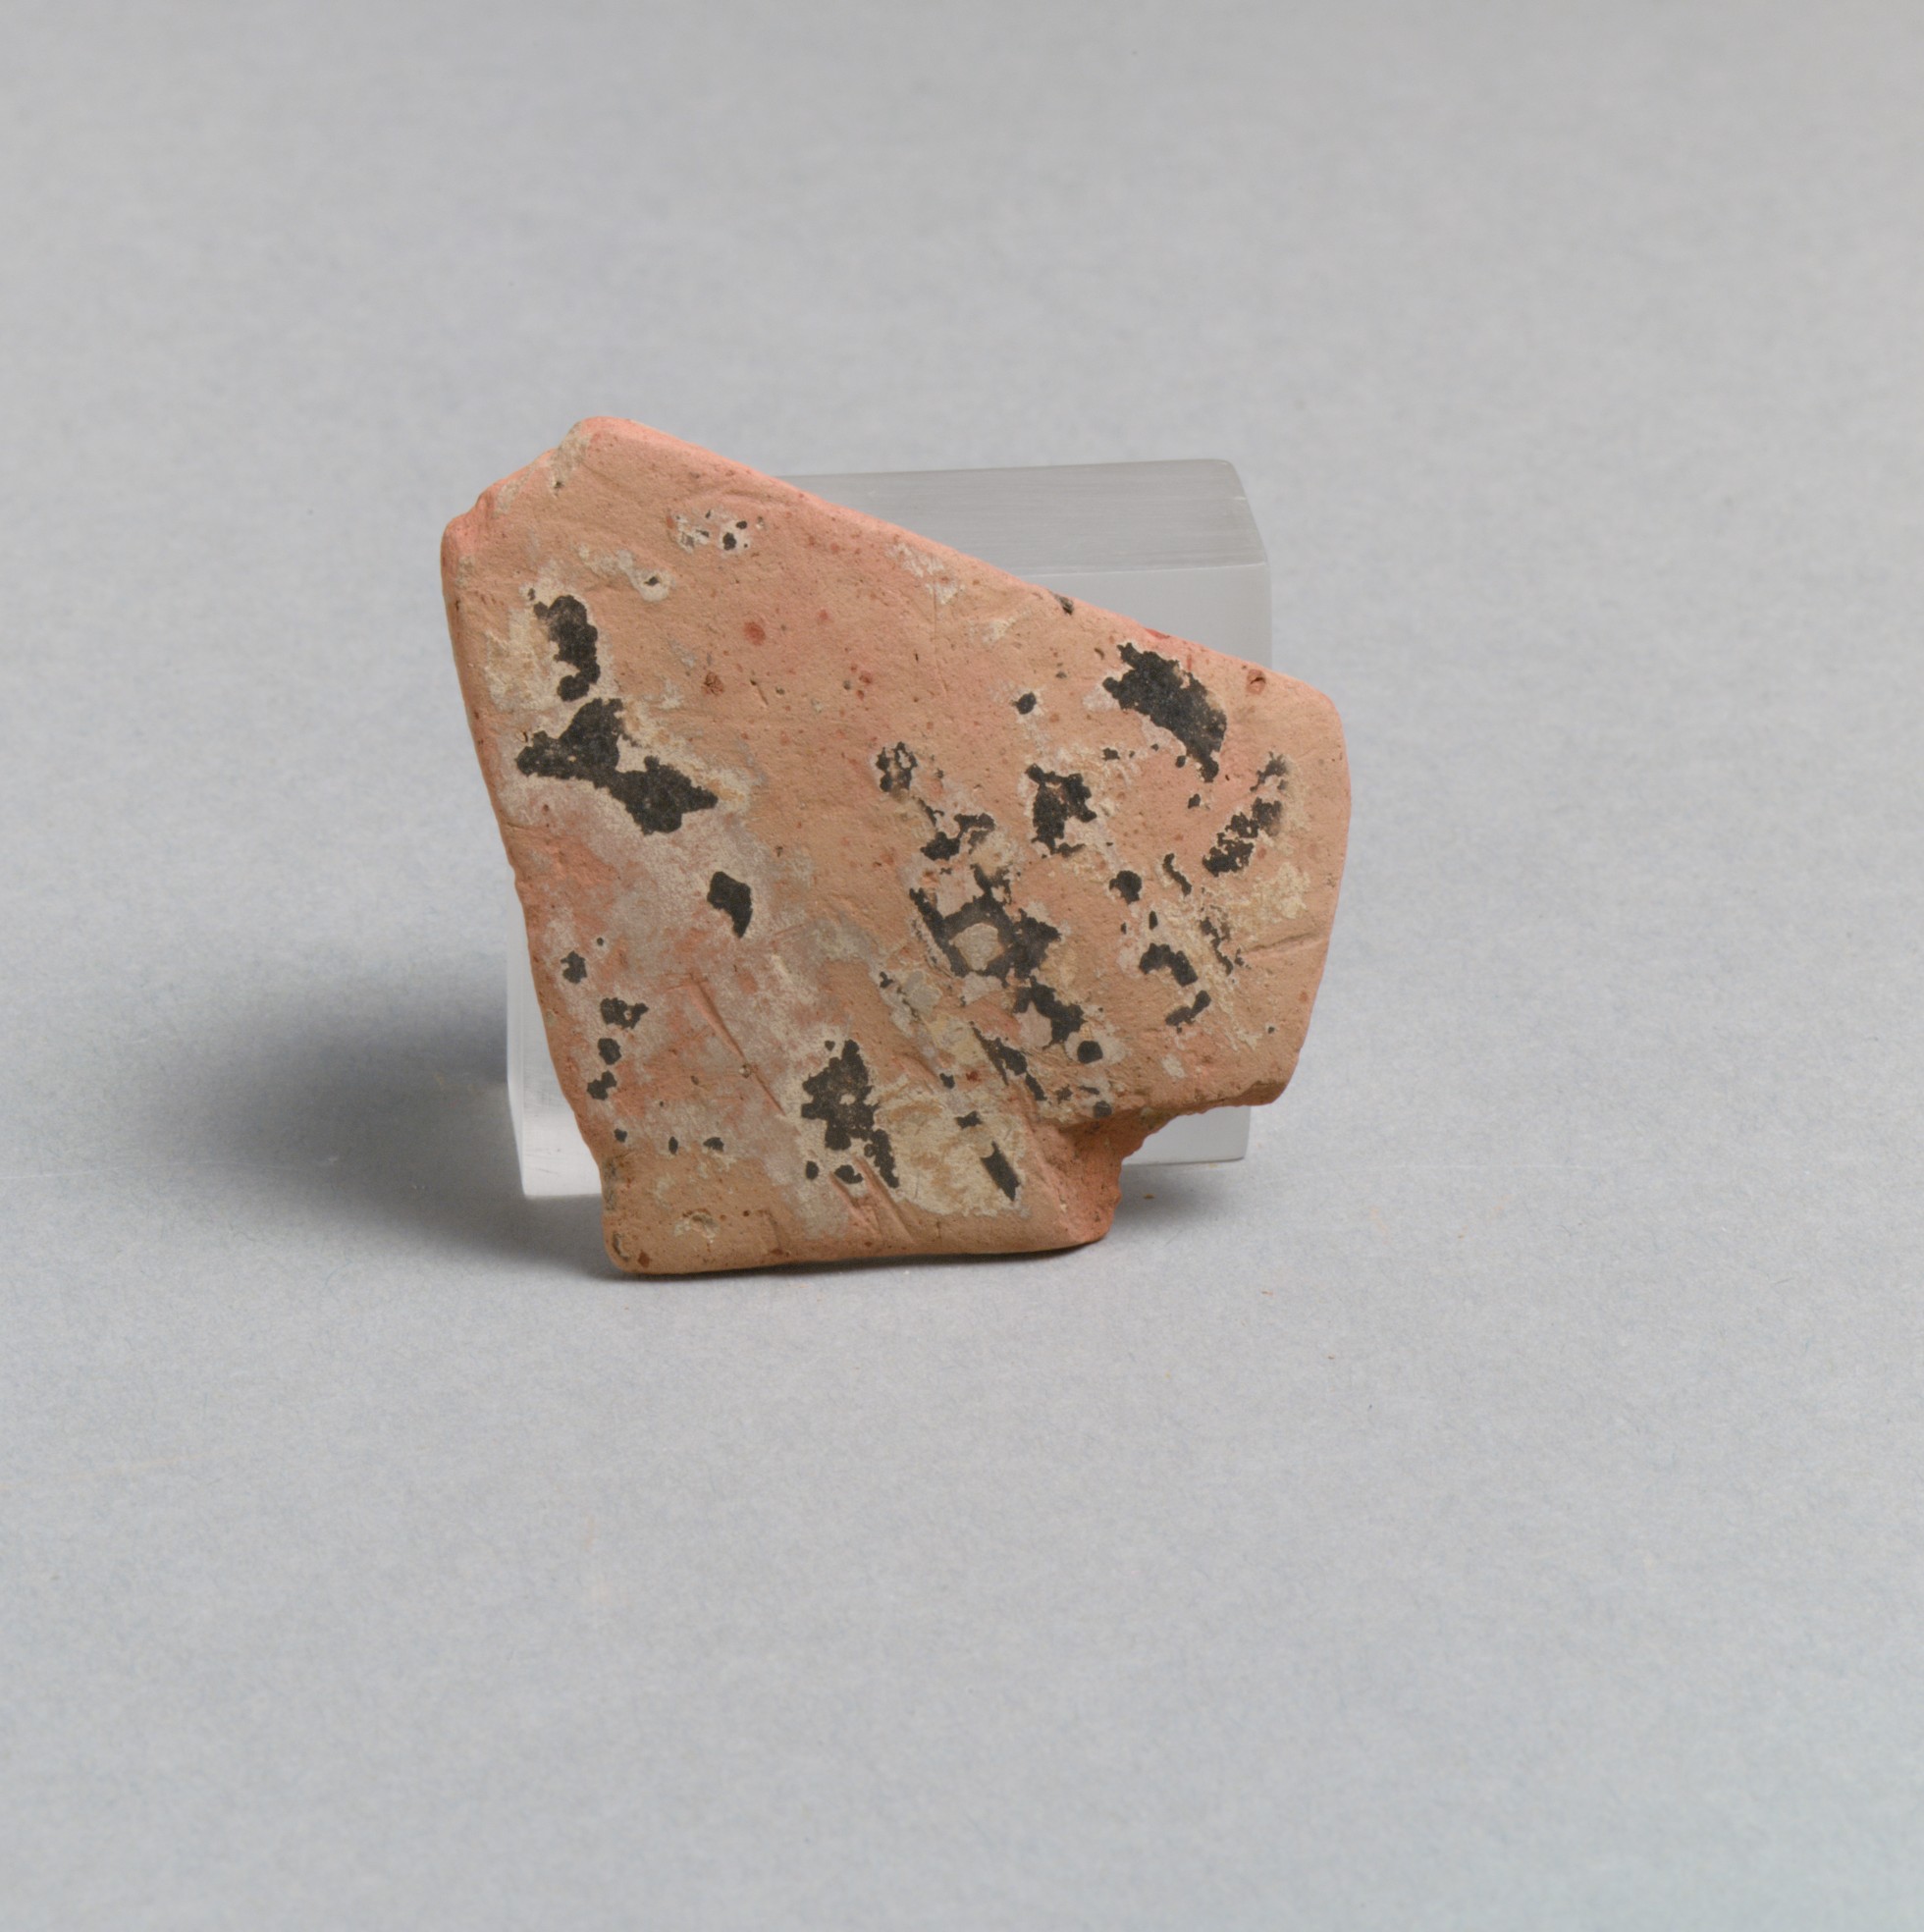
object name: vase fragment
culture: greek, laconian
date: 1100-700 BCE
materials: terracotta